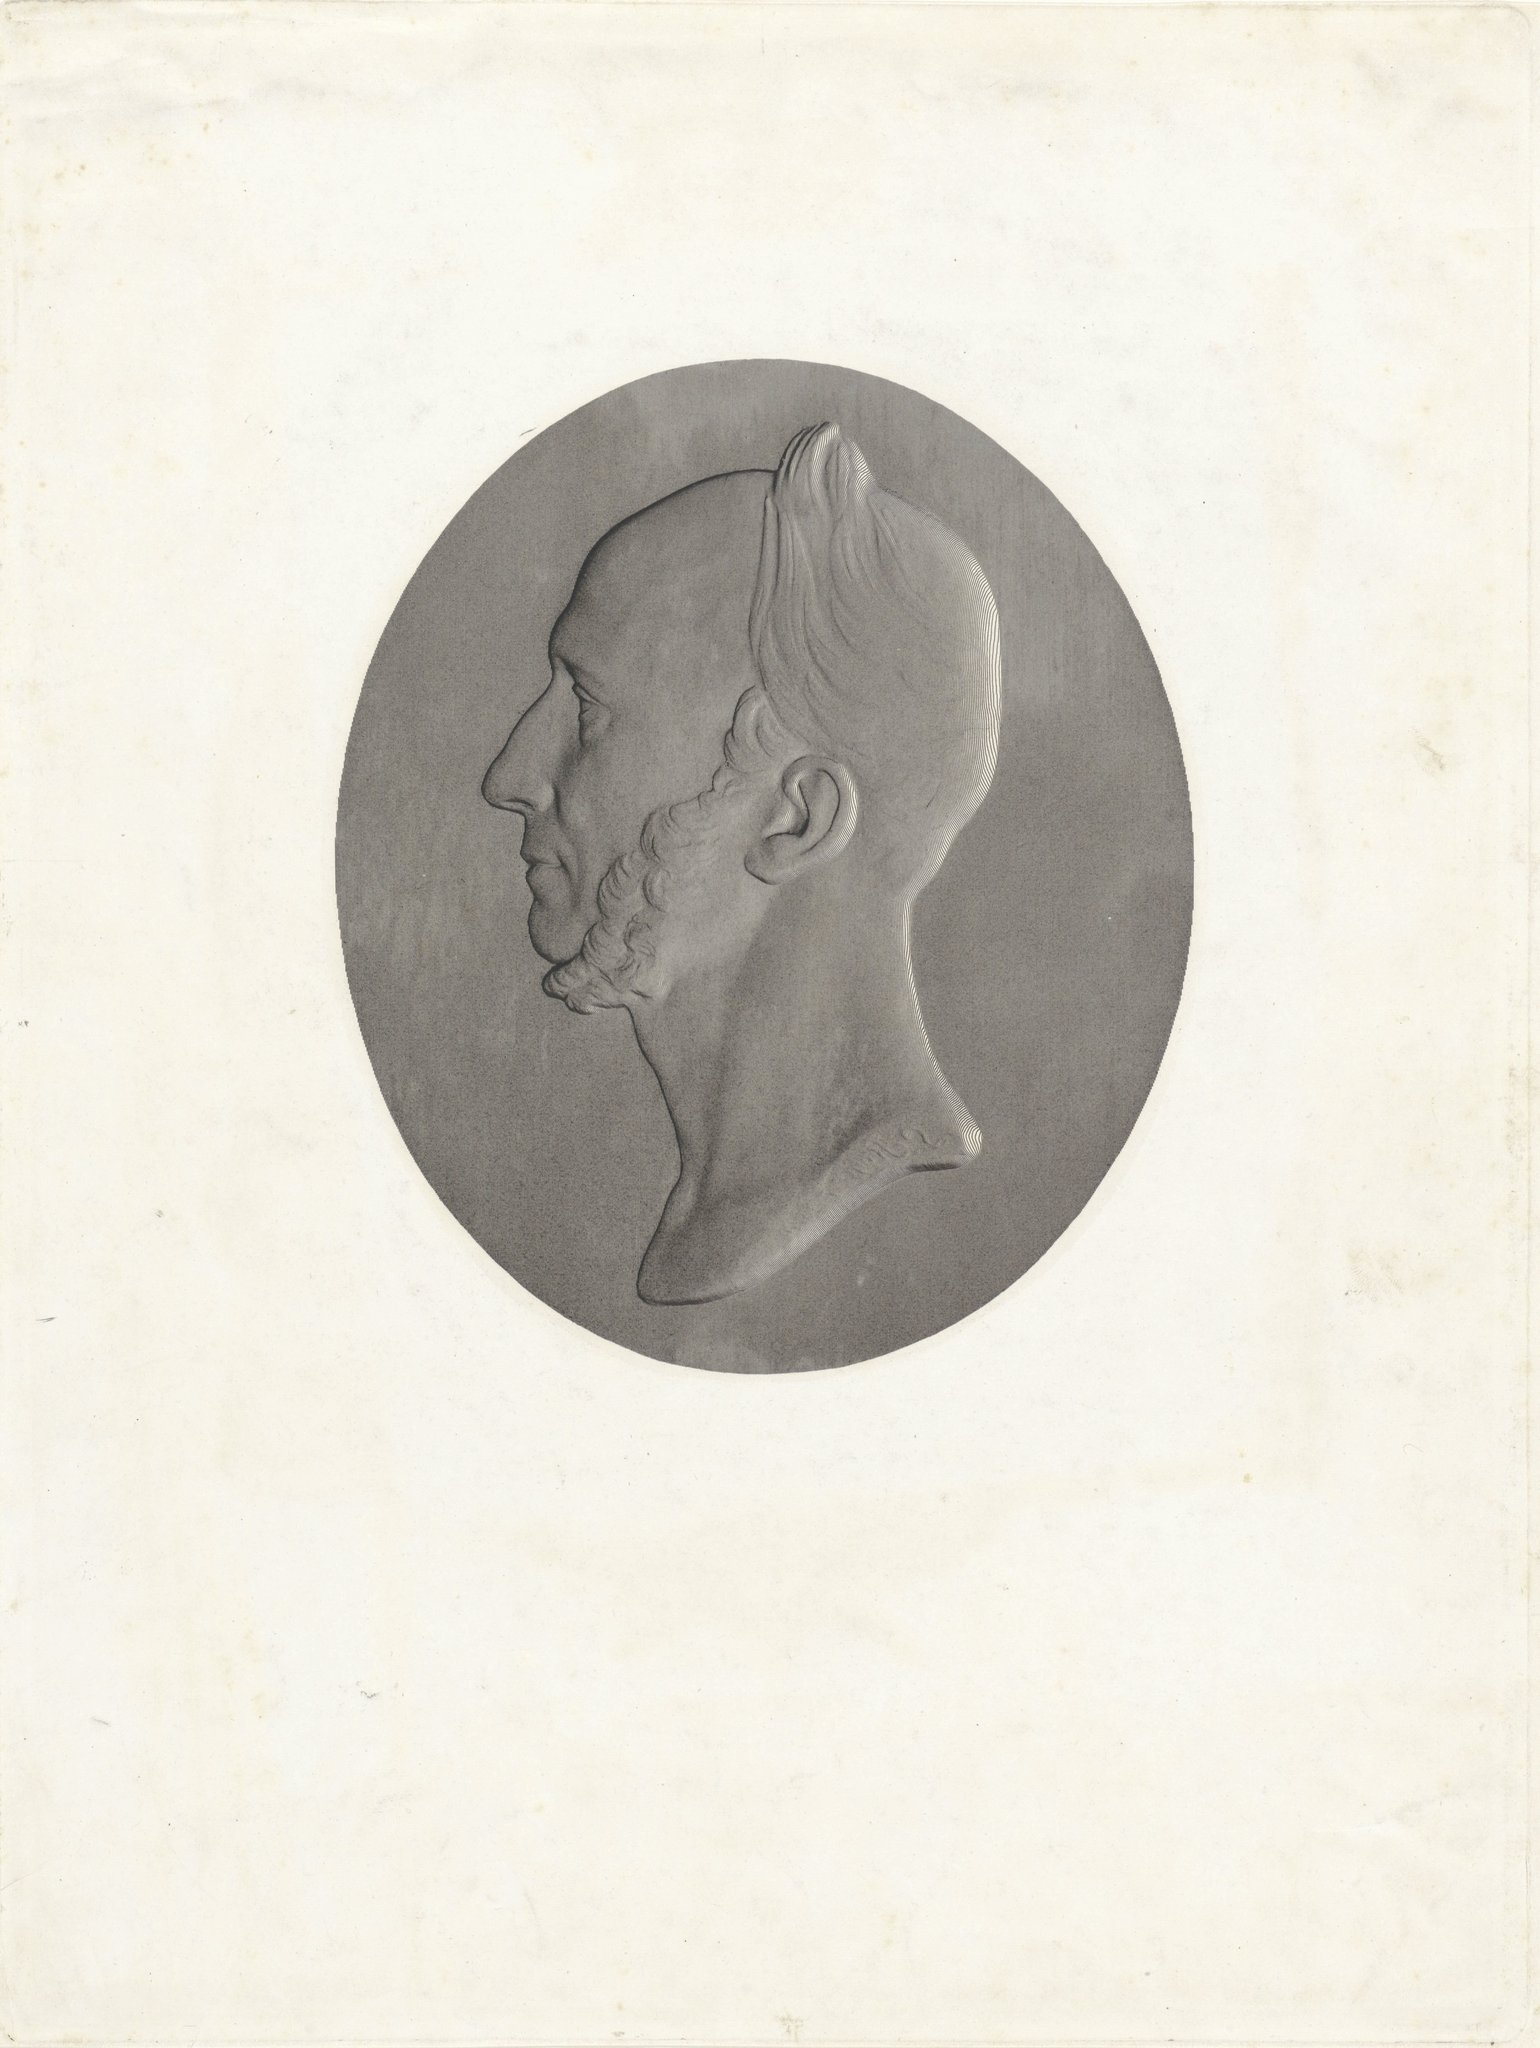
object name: print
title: Portret van Willem II, koning der Nederlanden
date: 1840-1842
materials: paper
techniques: engraving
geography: the hague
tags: the hague, william ii of the netherlands, king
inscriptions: collector's mark: Lugt 2228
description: Portret van Willem II, koning der Nederlanden, in profiel.